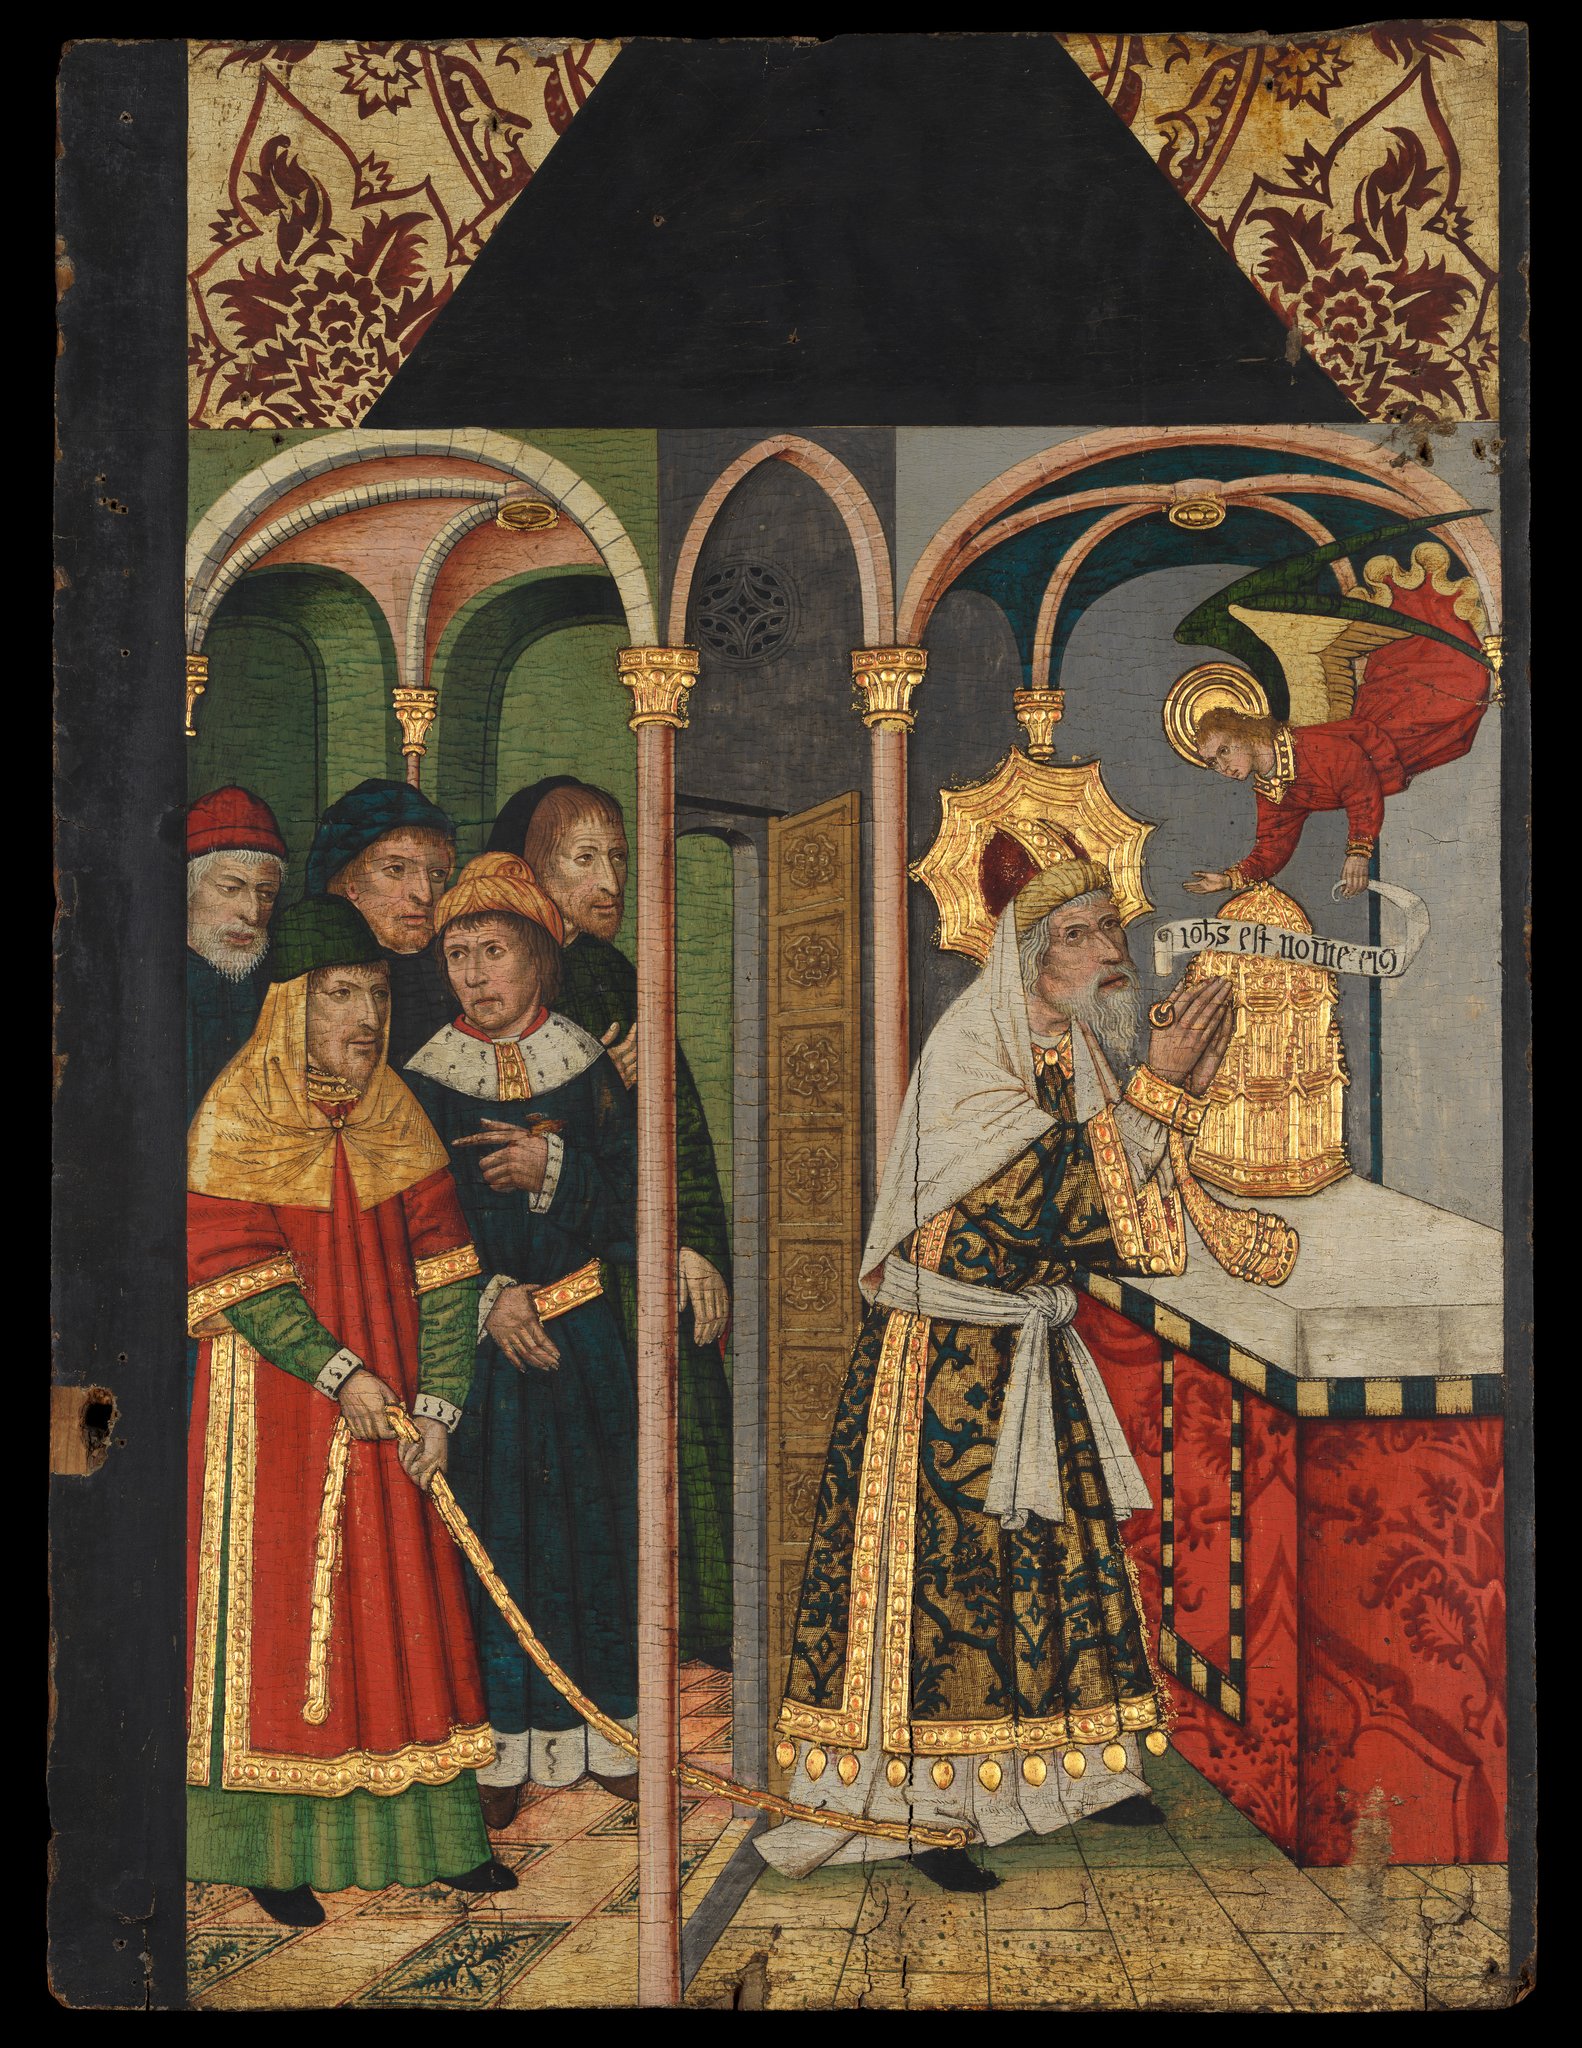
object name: painting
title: Panel with the Angel Appearing to Zacharias (from a Retable depicting Saint John the Baptist and scenes from his life)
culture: spanish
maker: domingo ram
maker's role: artist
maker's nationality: spanish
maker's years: 1464-1507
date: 1464-1507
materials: gold leaf, paint, wood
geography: spain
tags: men,angels,saint john the baptist,saints